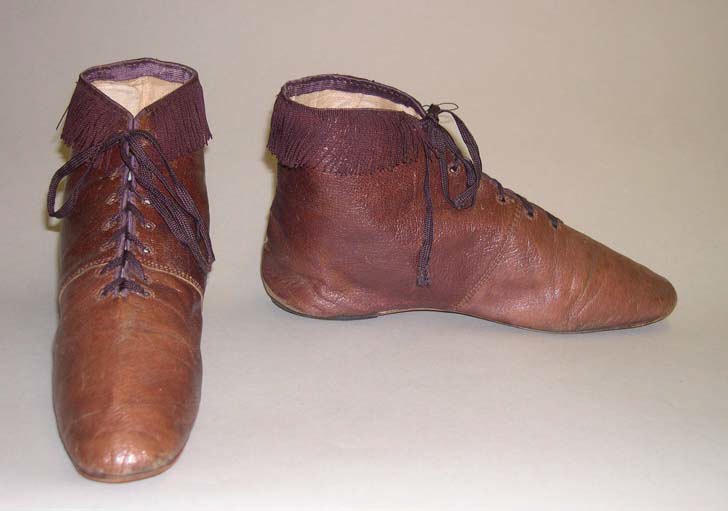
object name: boot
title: Boots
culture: american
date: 1810-1829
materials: leather